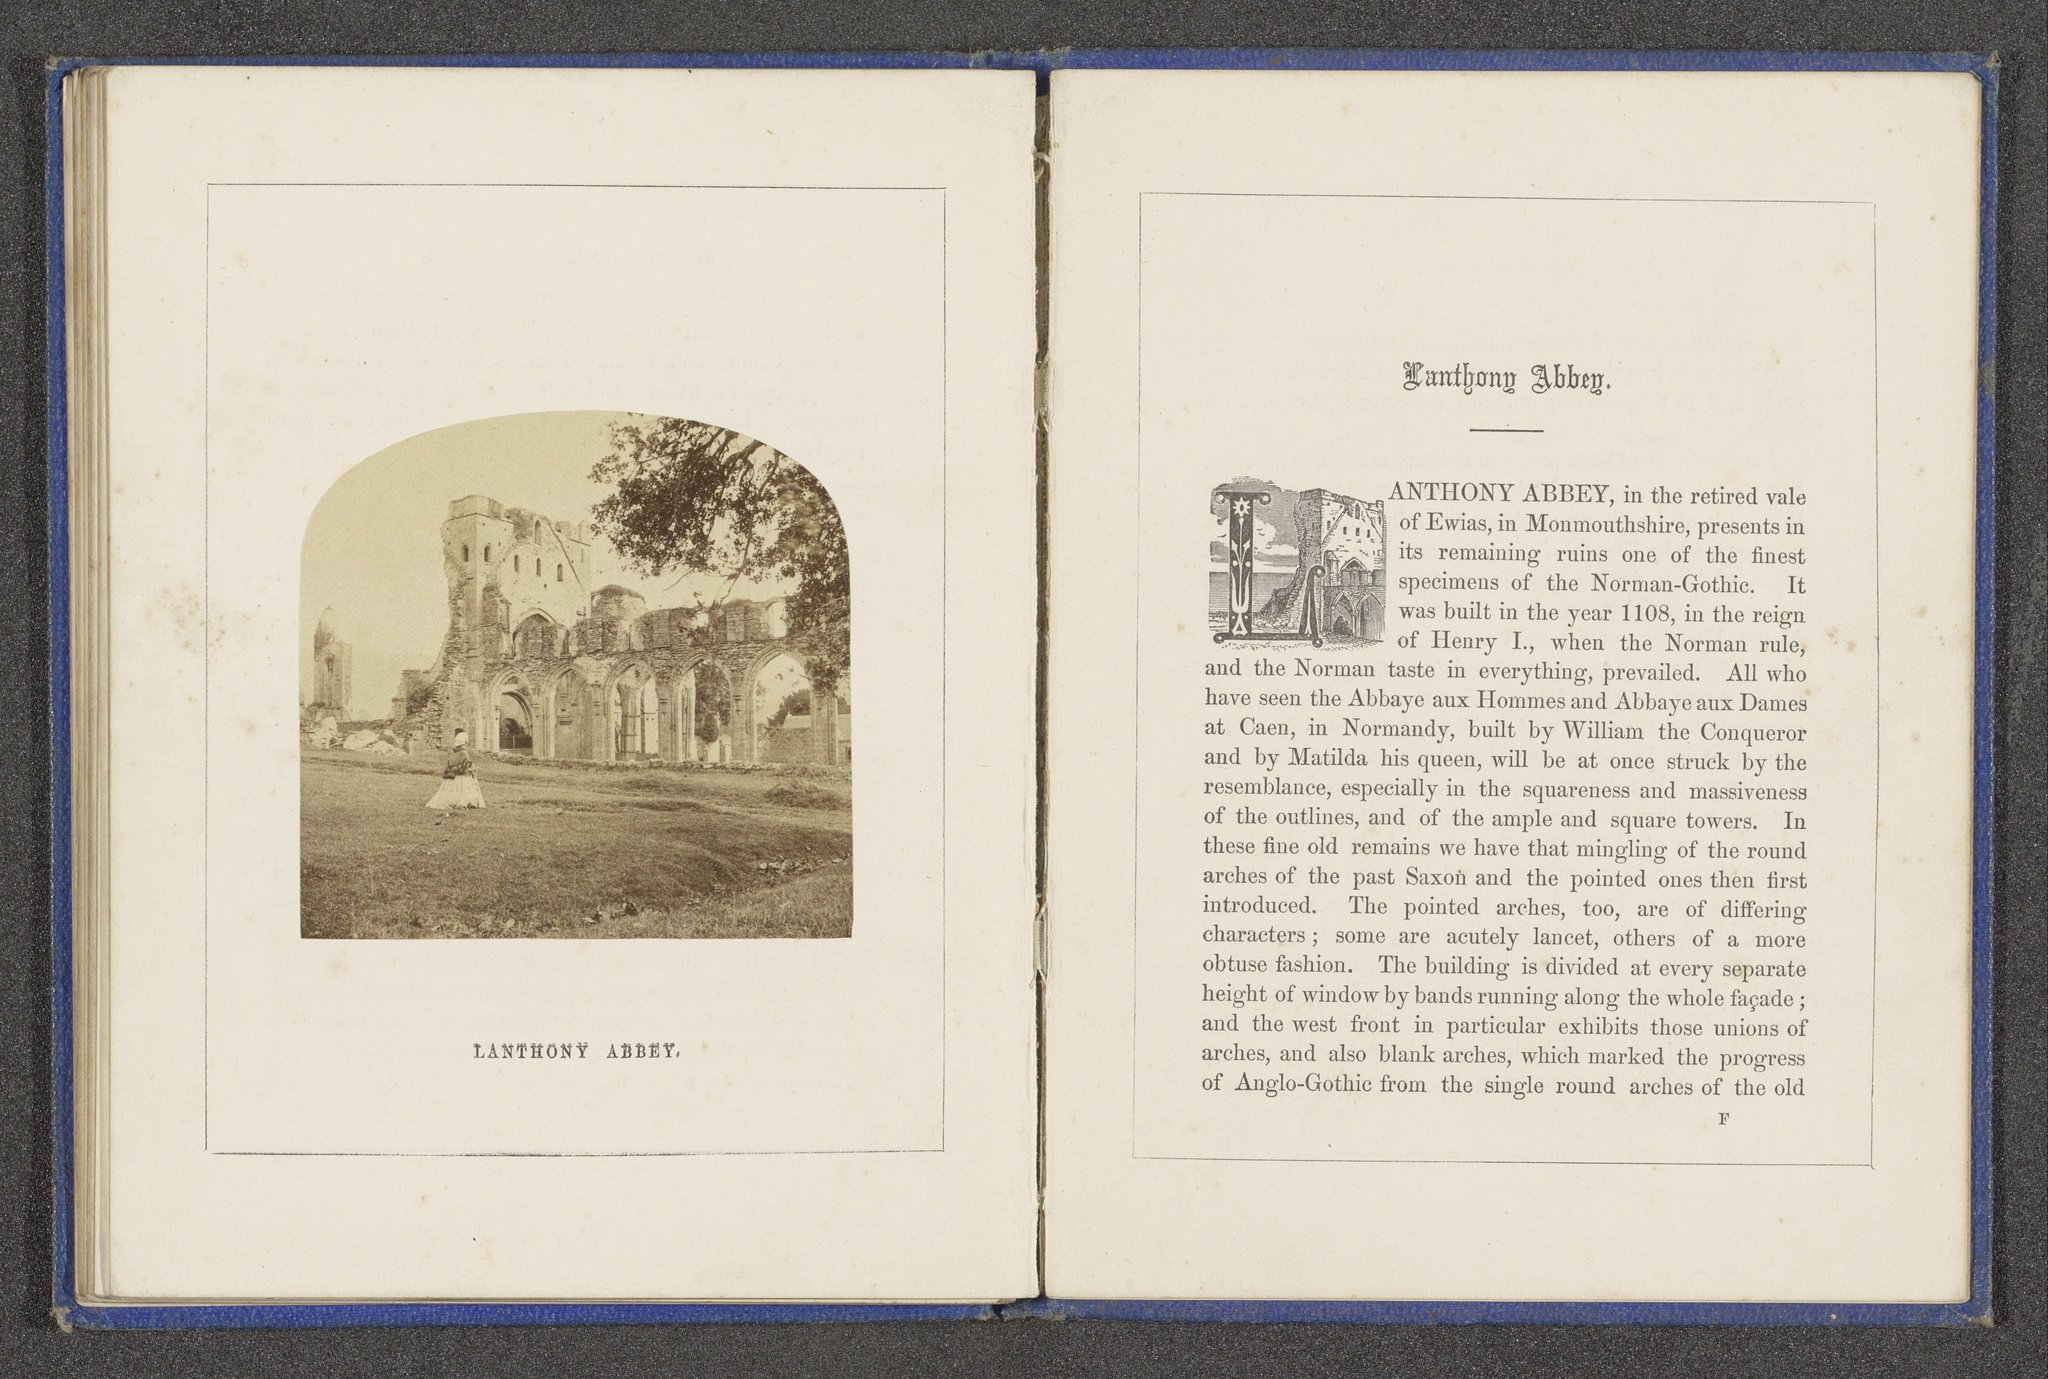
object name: photograph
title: Lanthony Abbey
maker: francis bedford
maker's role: print maker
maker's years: 1815-1894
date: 1853-1863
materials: photographic support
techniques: albumen print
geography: llanthony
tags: ruin of church, monastery, etc.